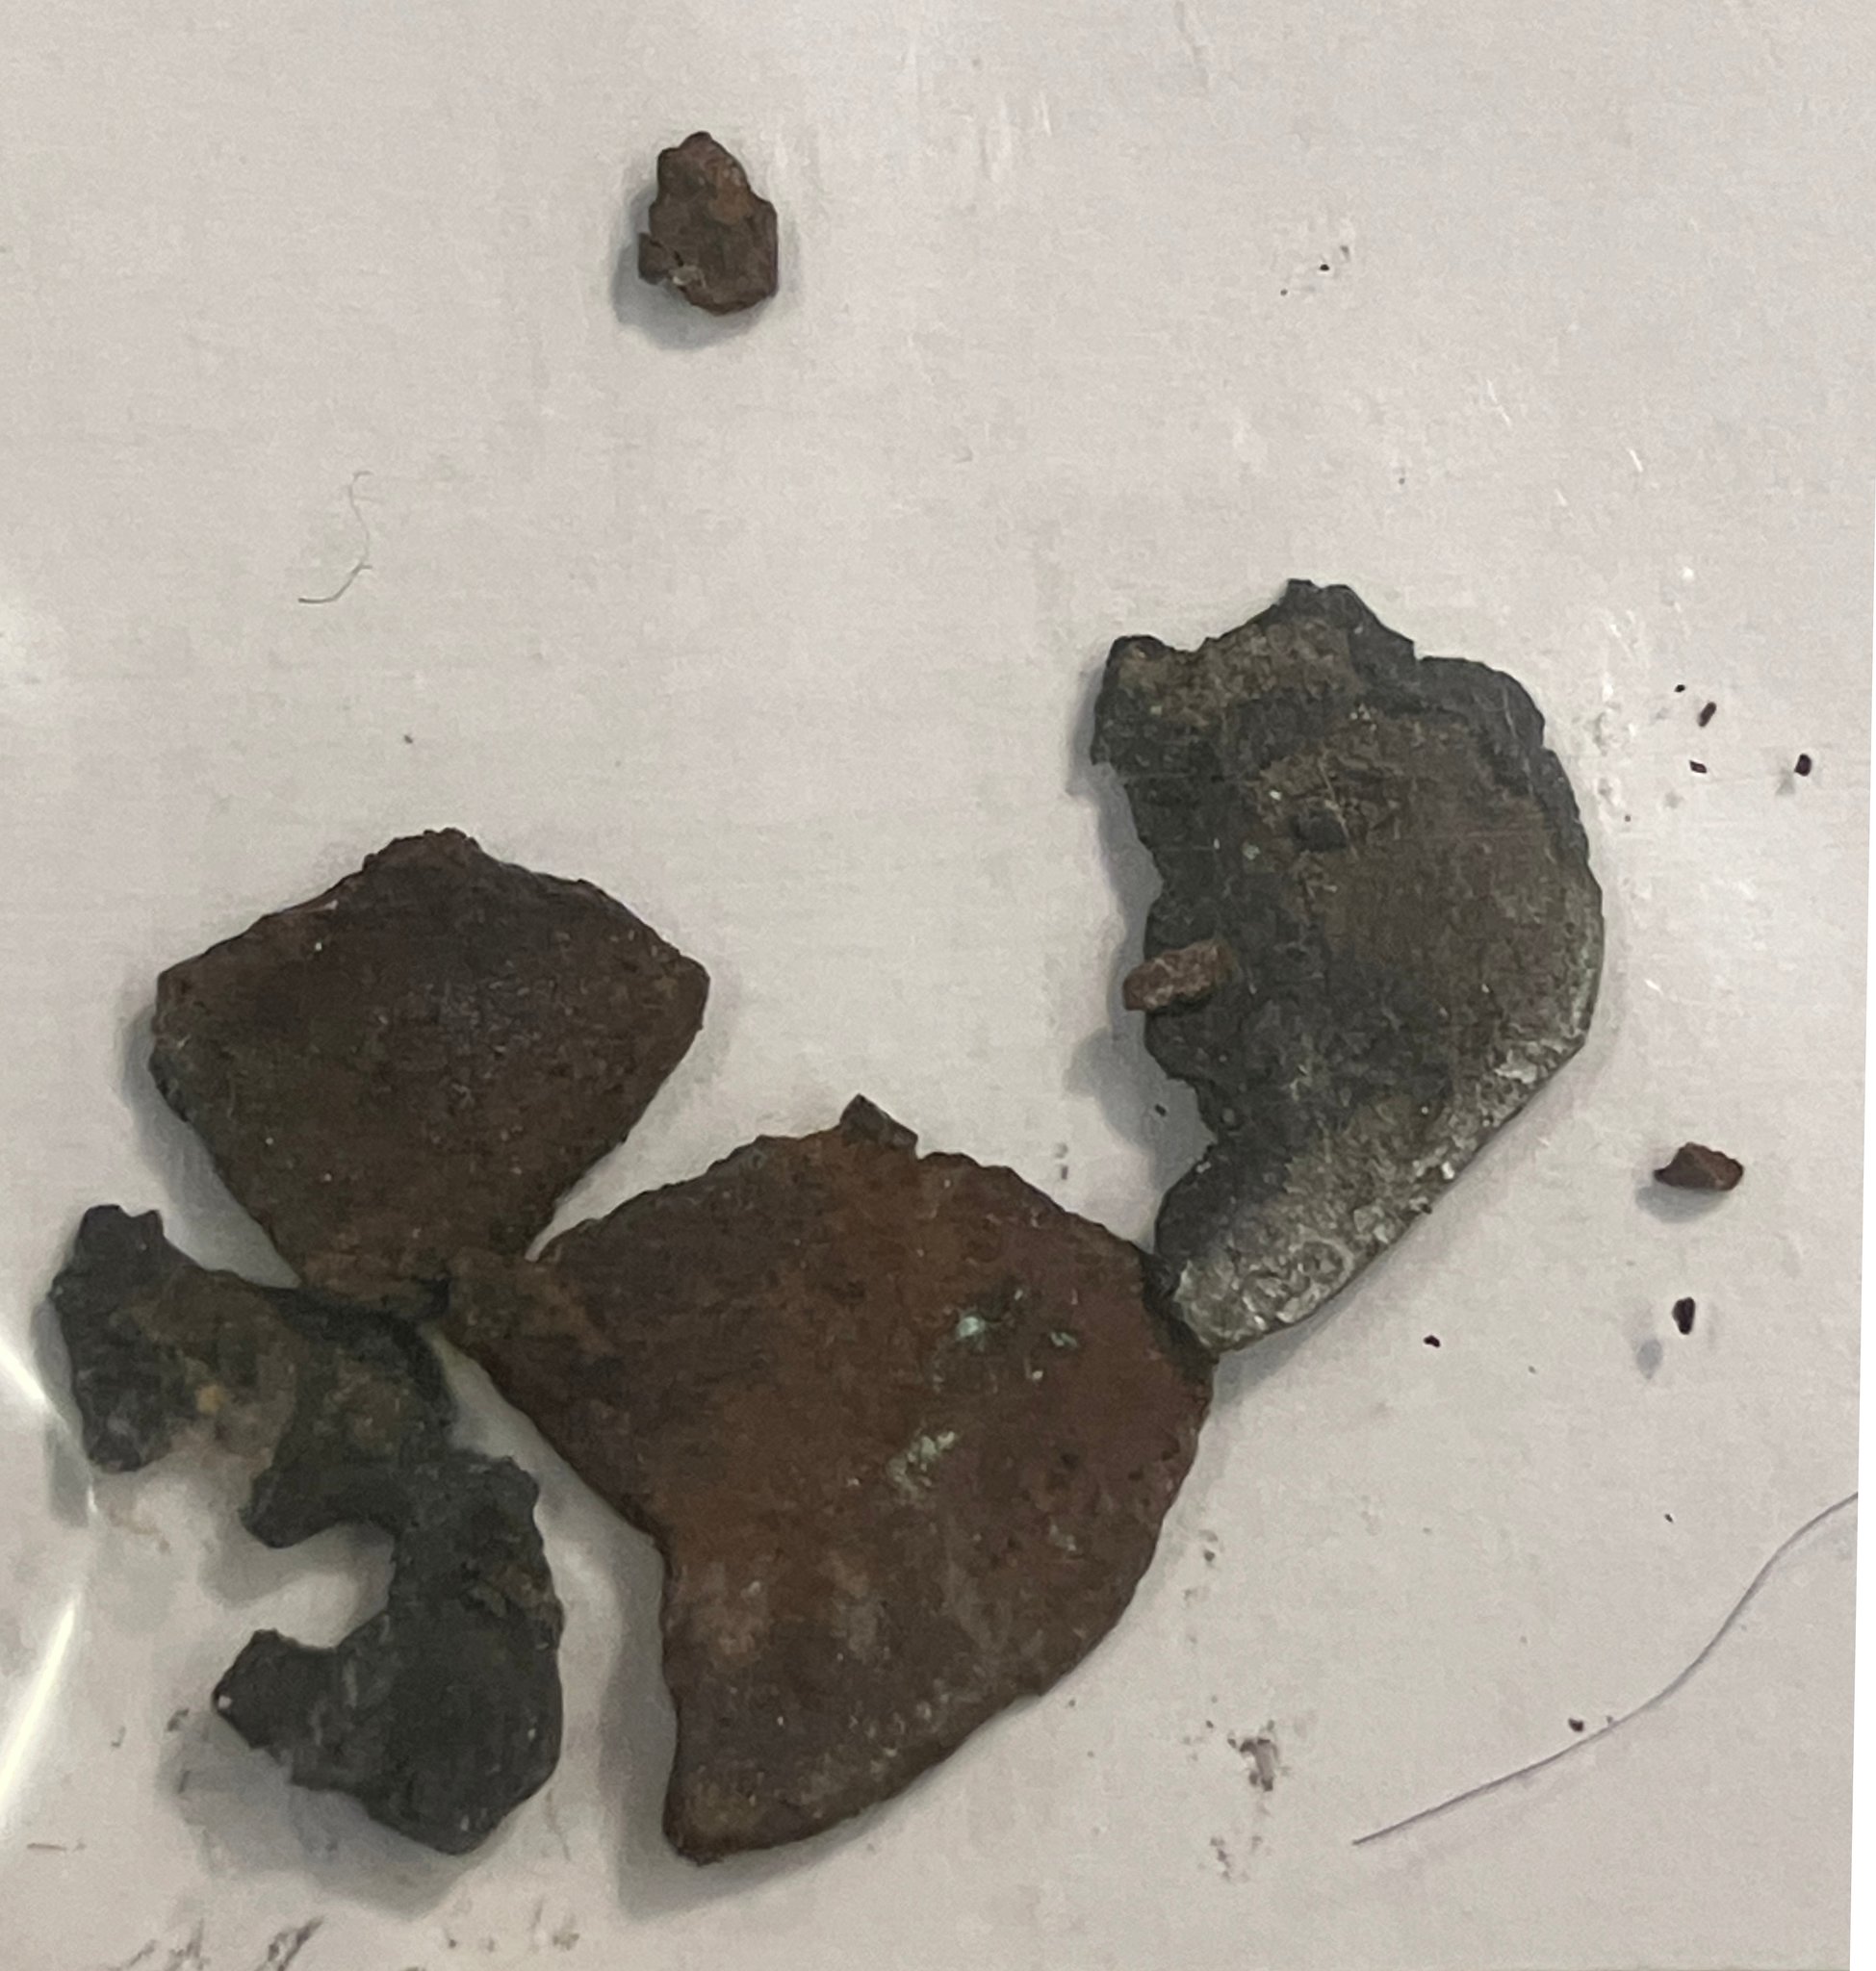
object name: coin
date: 153-770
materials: copper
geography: iran